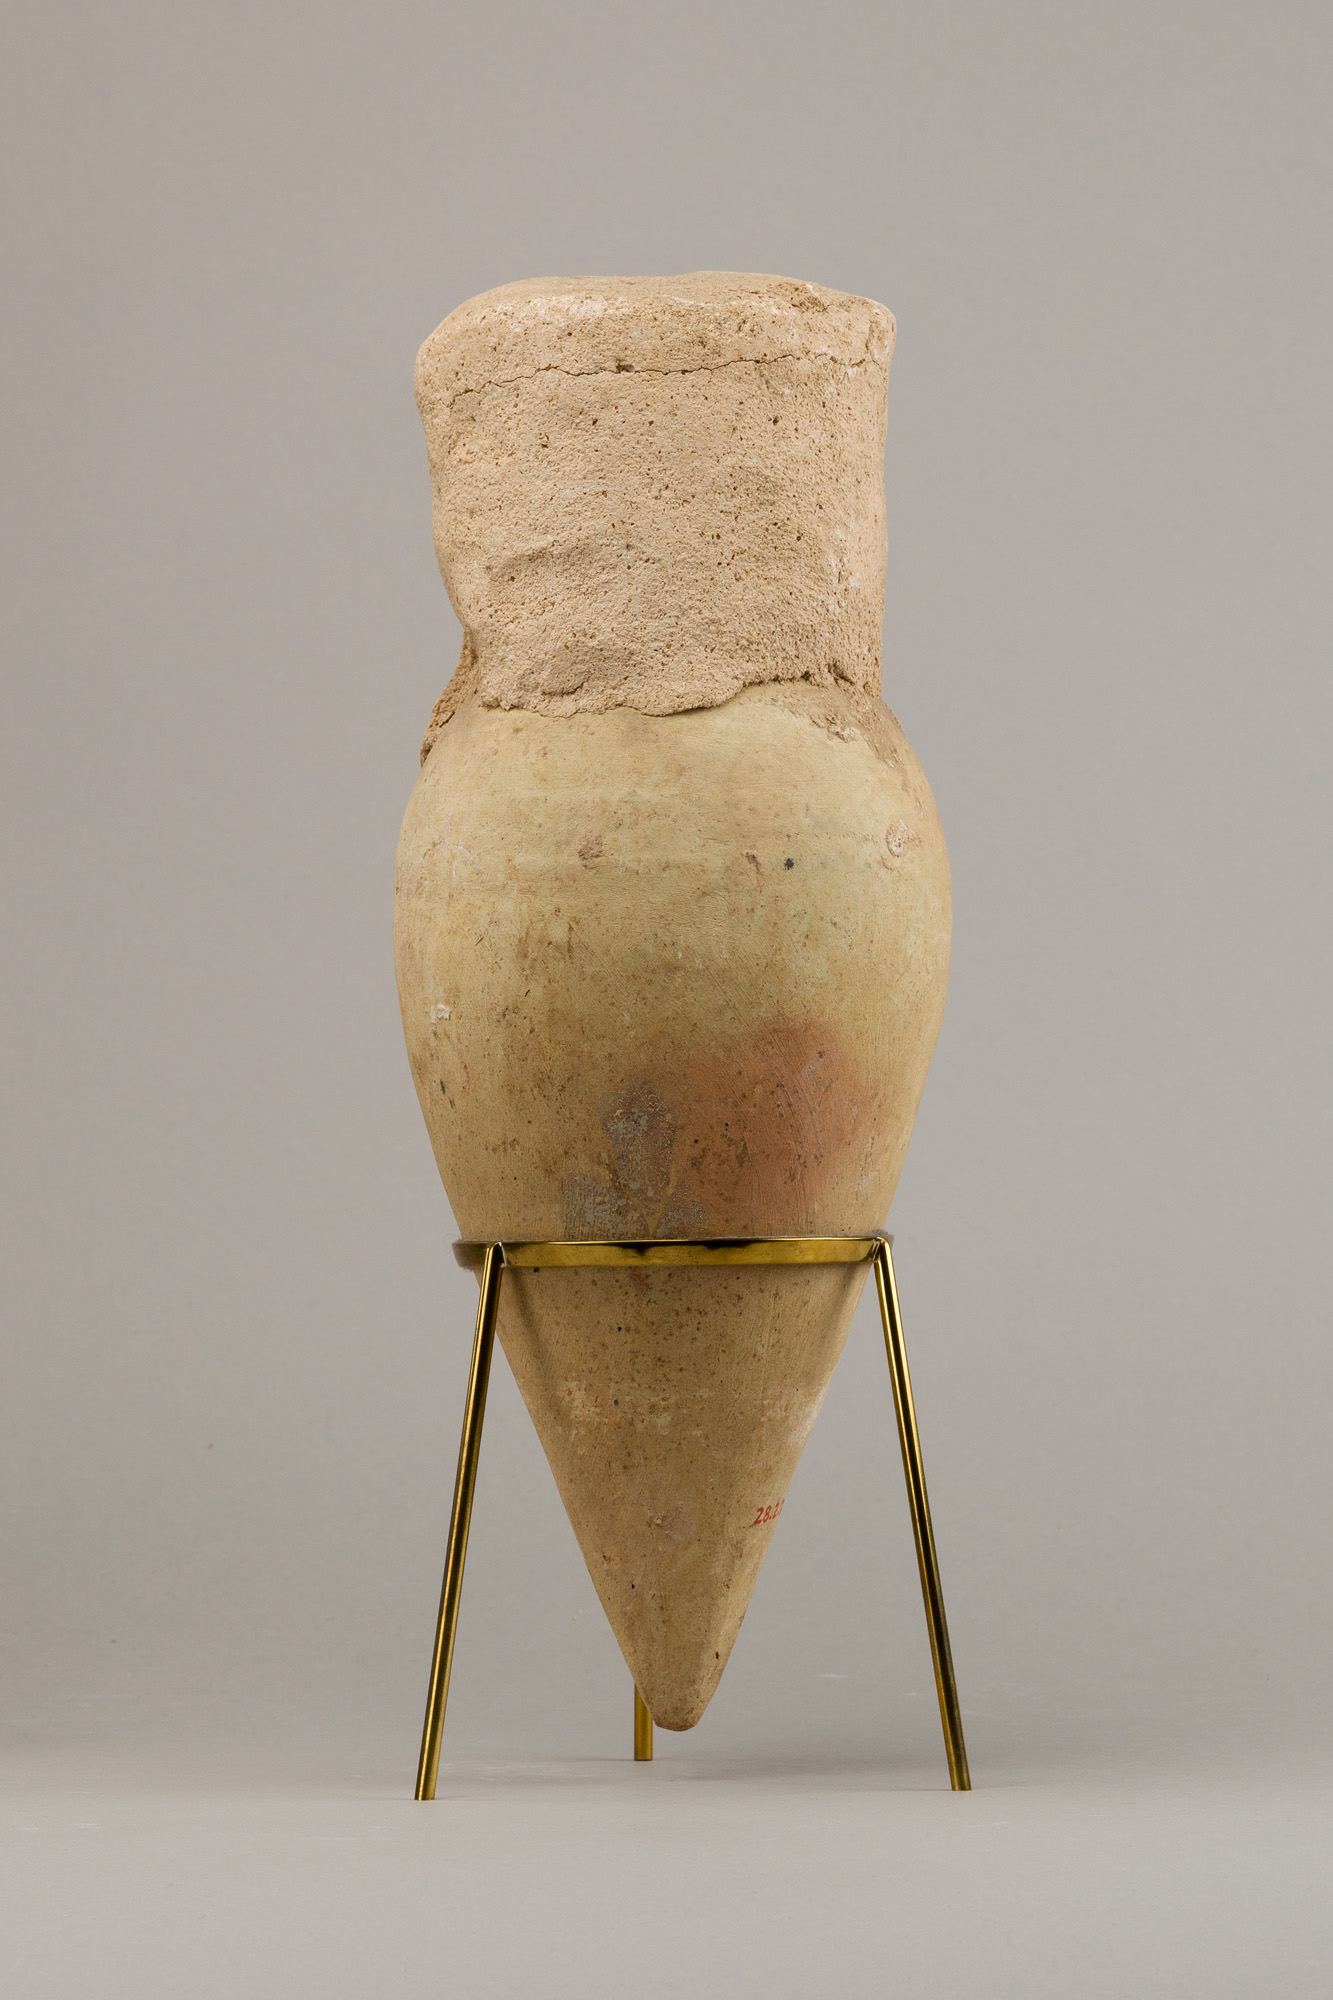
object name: jar, sealed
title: Jar with pointed base and intact seal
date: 2649-2100 BCE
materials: pottery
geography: egypt